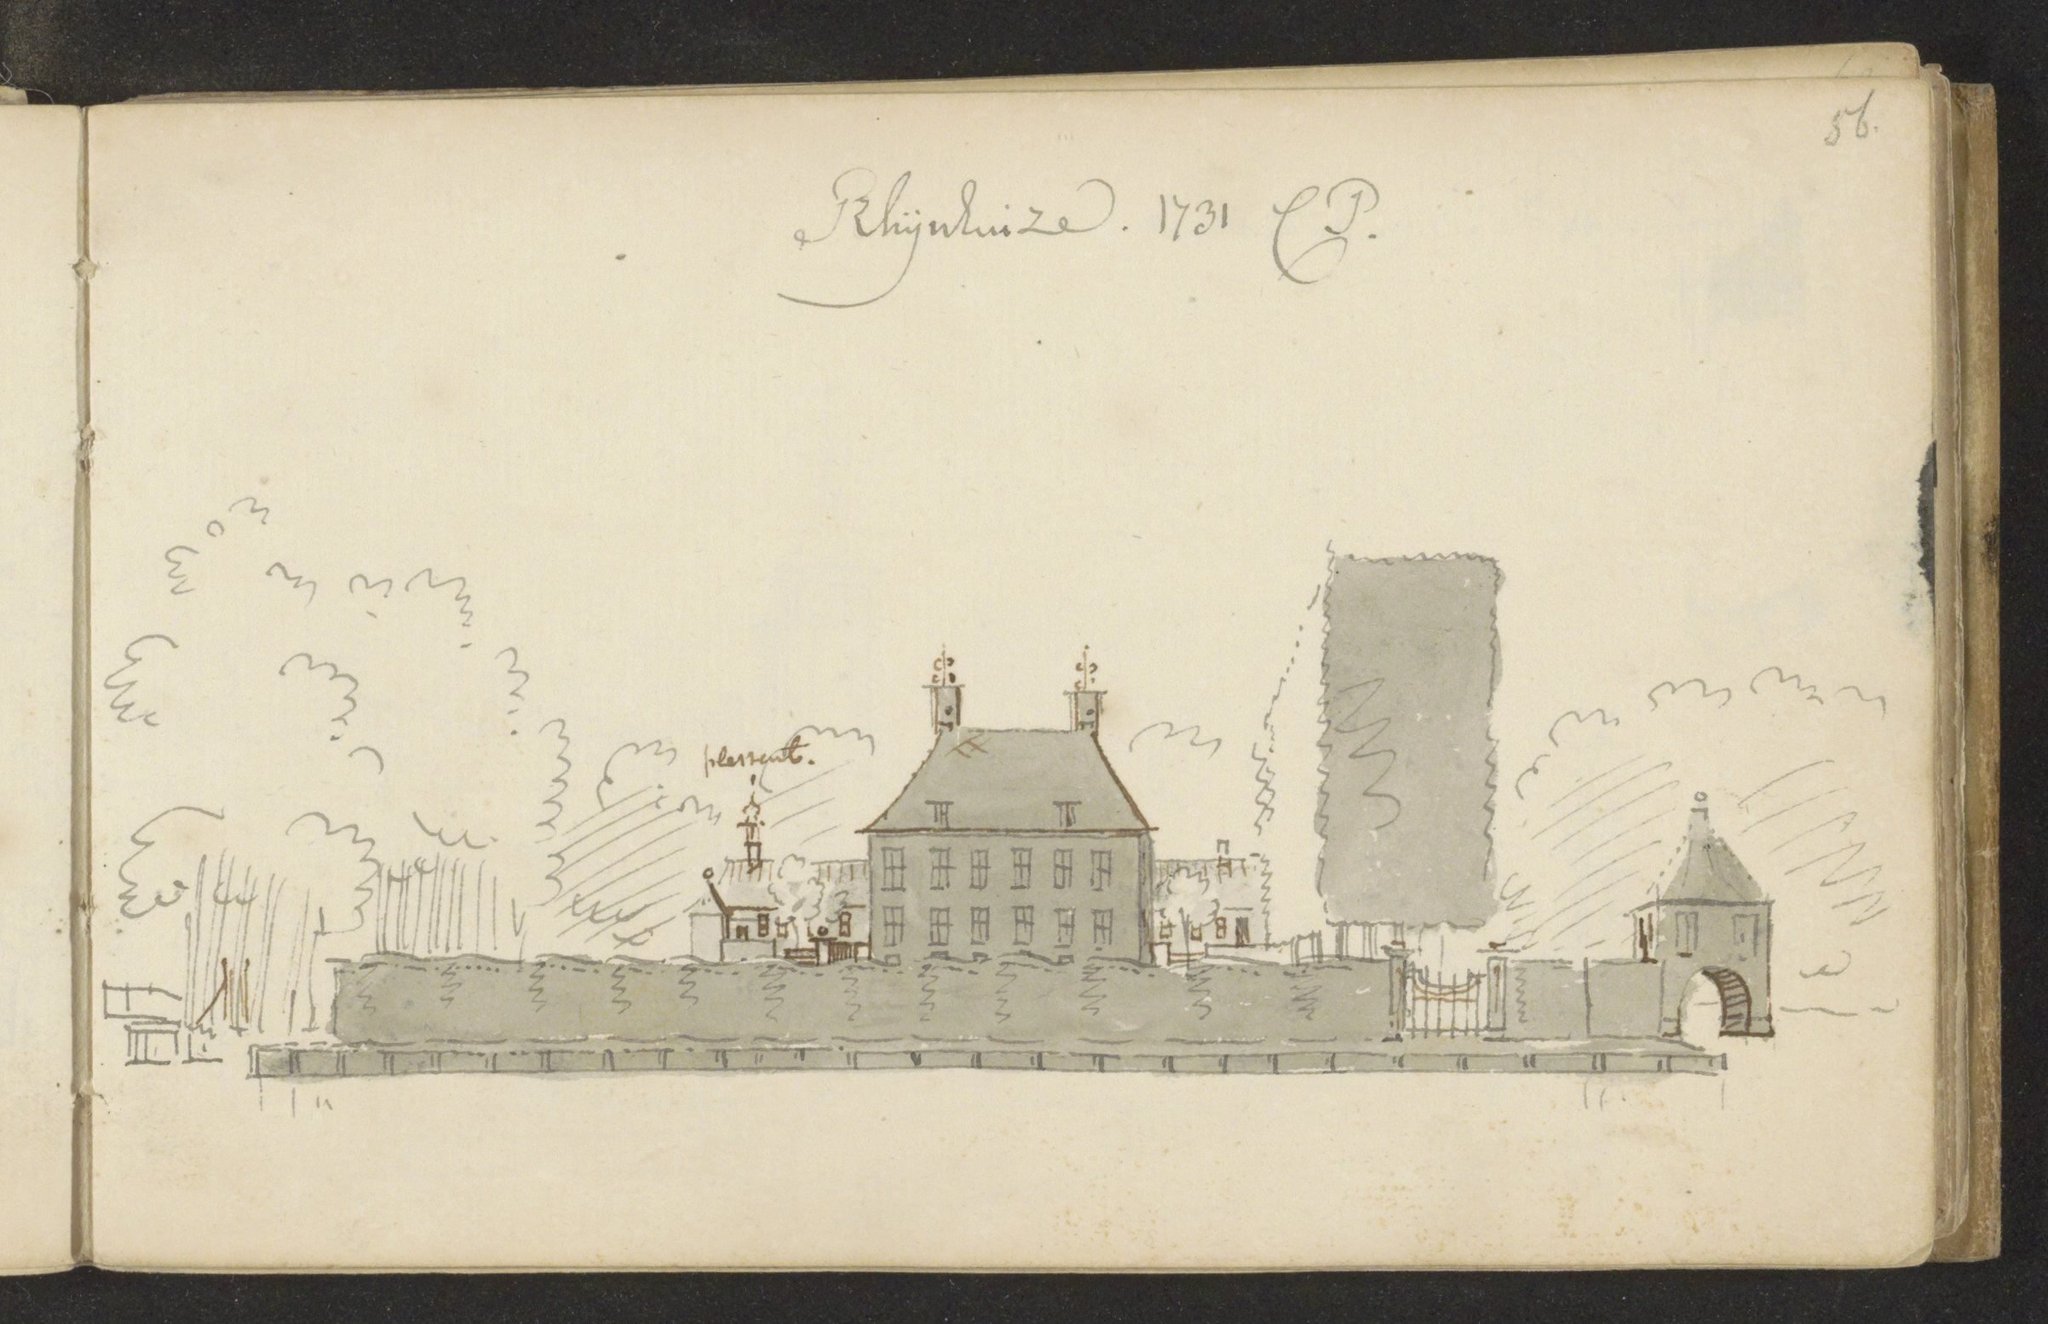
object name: sketchbook leaf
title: Kasteel Rijnhuizen te Nieuwegein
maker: abraham de haen (ii)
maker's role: draughtsman, print maker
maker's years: 1707-1748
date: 1731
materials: ink, paper, pencil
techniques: brush, pen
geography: nieuwegein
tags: castle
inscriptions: date and inscription: ‘Rhijnhuize.1731 CP.’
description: Blad 56 recto uit een schetsboek met 78 bladen.